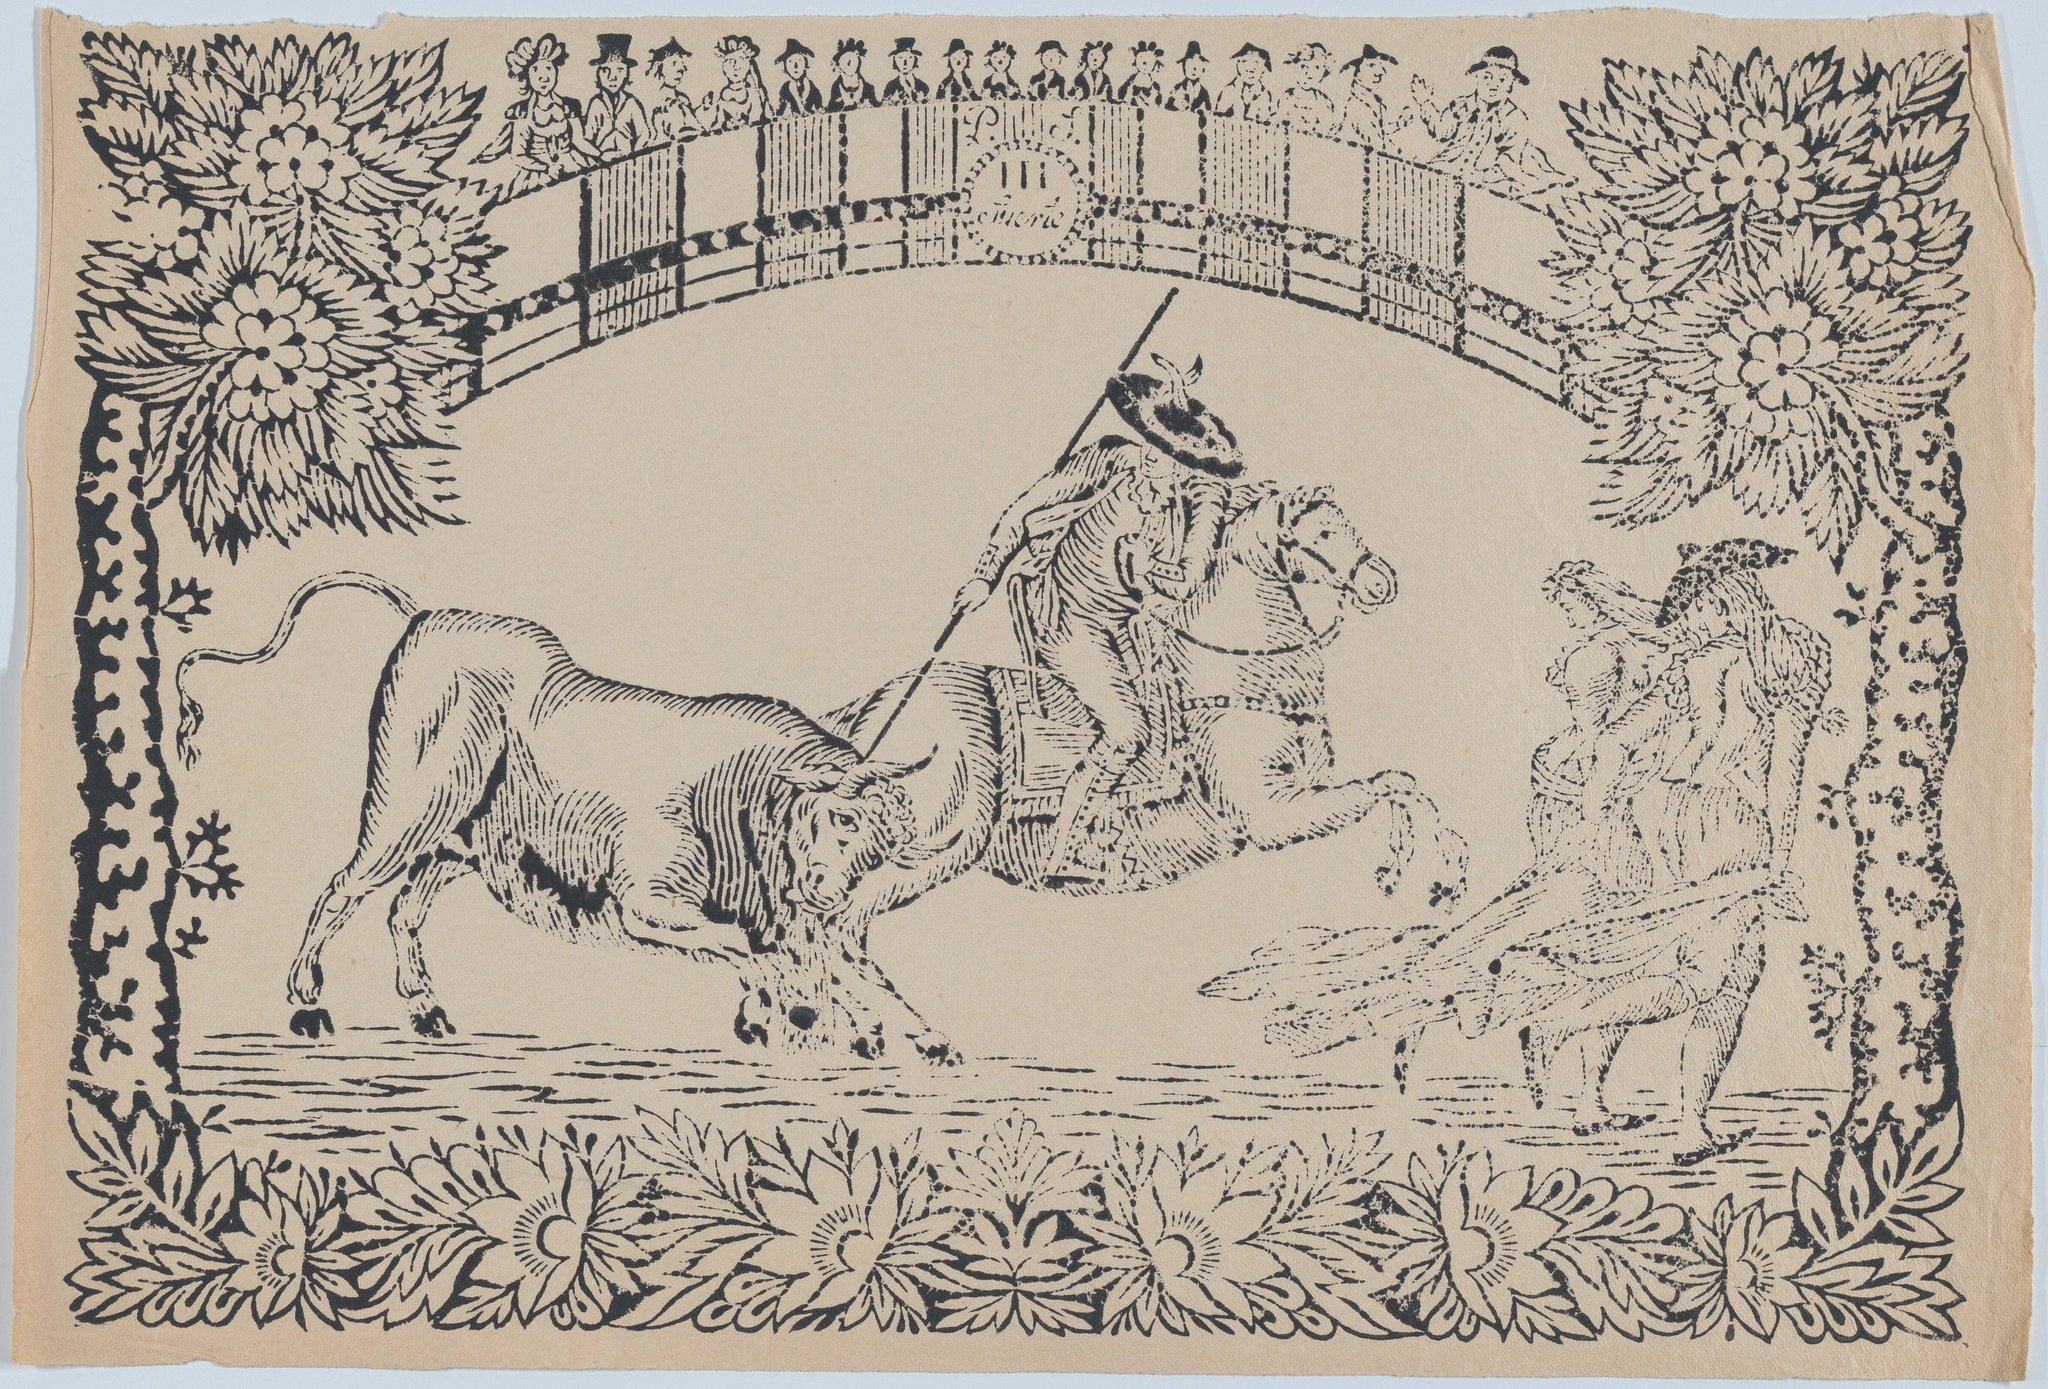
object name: print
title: Suerte III: Picador stabbing a bull; two toreros running to right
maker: anonymous, spanish, 19th century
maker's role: artist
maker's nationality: spanish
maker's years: 1800-1900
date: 1850-1880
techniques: woodcut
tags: men,women,bulls,horses,flowers